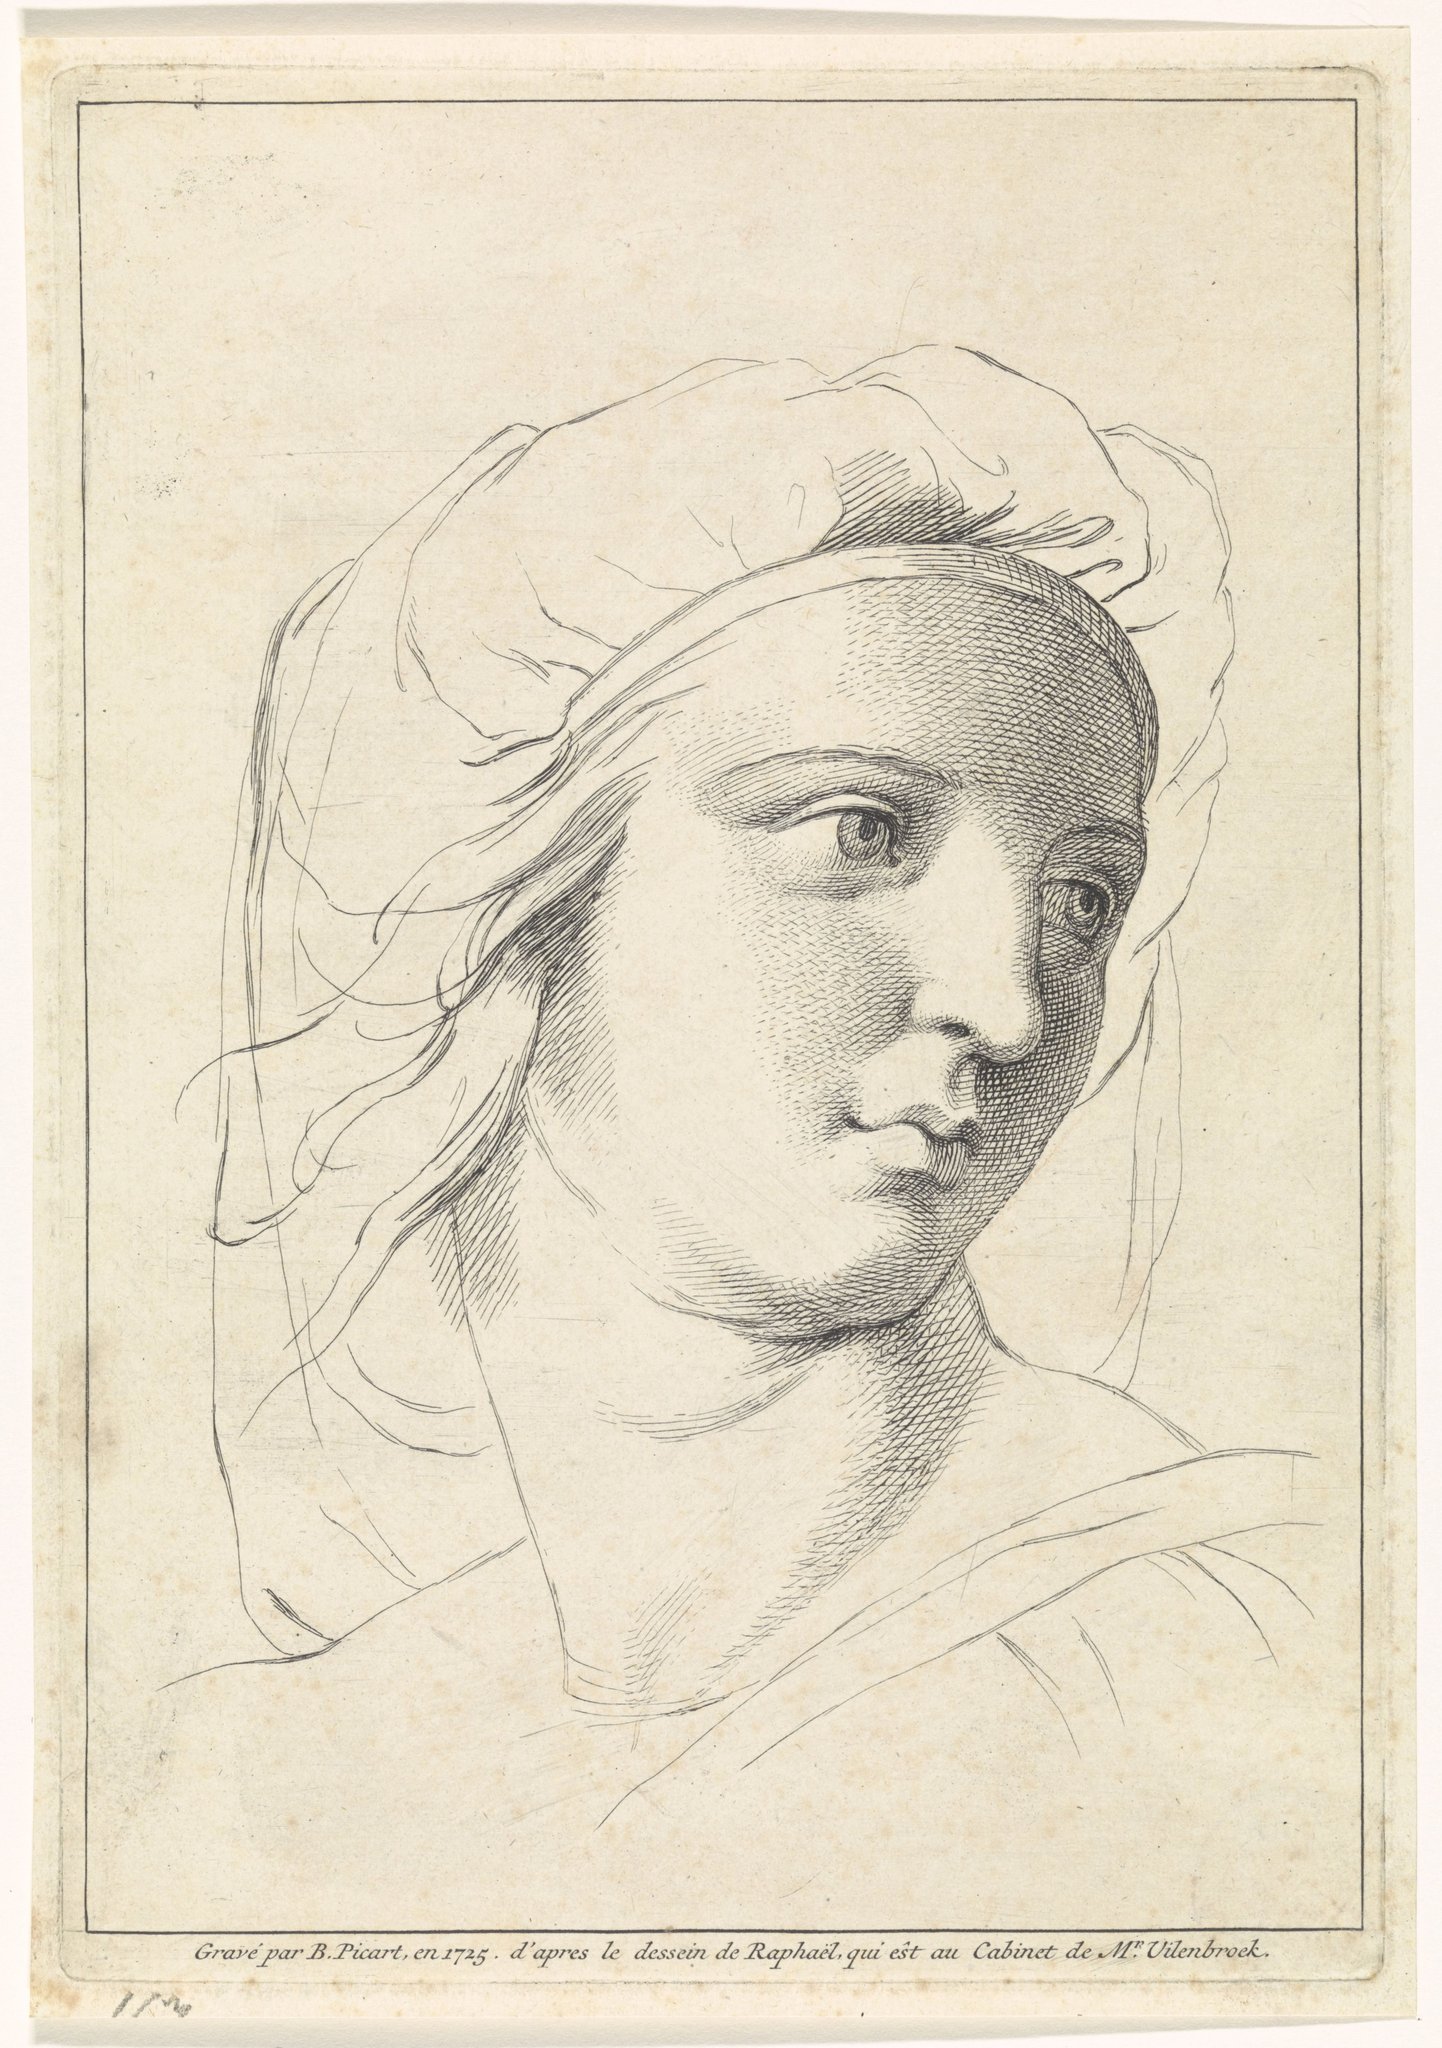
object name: print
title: Studie van een vrouwenhoofd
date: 1725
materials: paper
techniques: etching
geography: amsterdam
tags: head (human) - aa - female human figure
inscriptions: collector's mark: Lugt 240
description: Genummerde staat van deze prent opgenomen in: Impostures innocentes, ou recueil d'estampes d'apres divers peintres (...) par Bernard Picart (...) avec son elogue historique et le catalogue de ses ouvrages. Amsterdam: weduwe Bernard Picart, 1734.